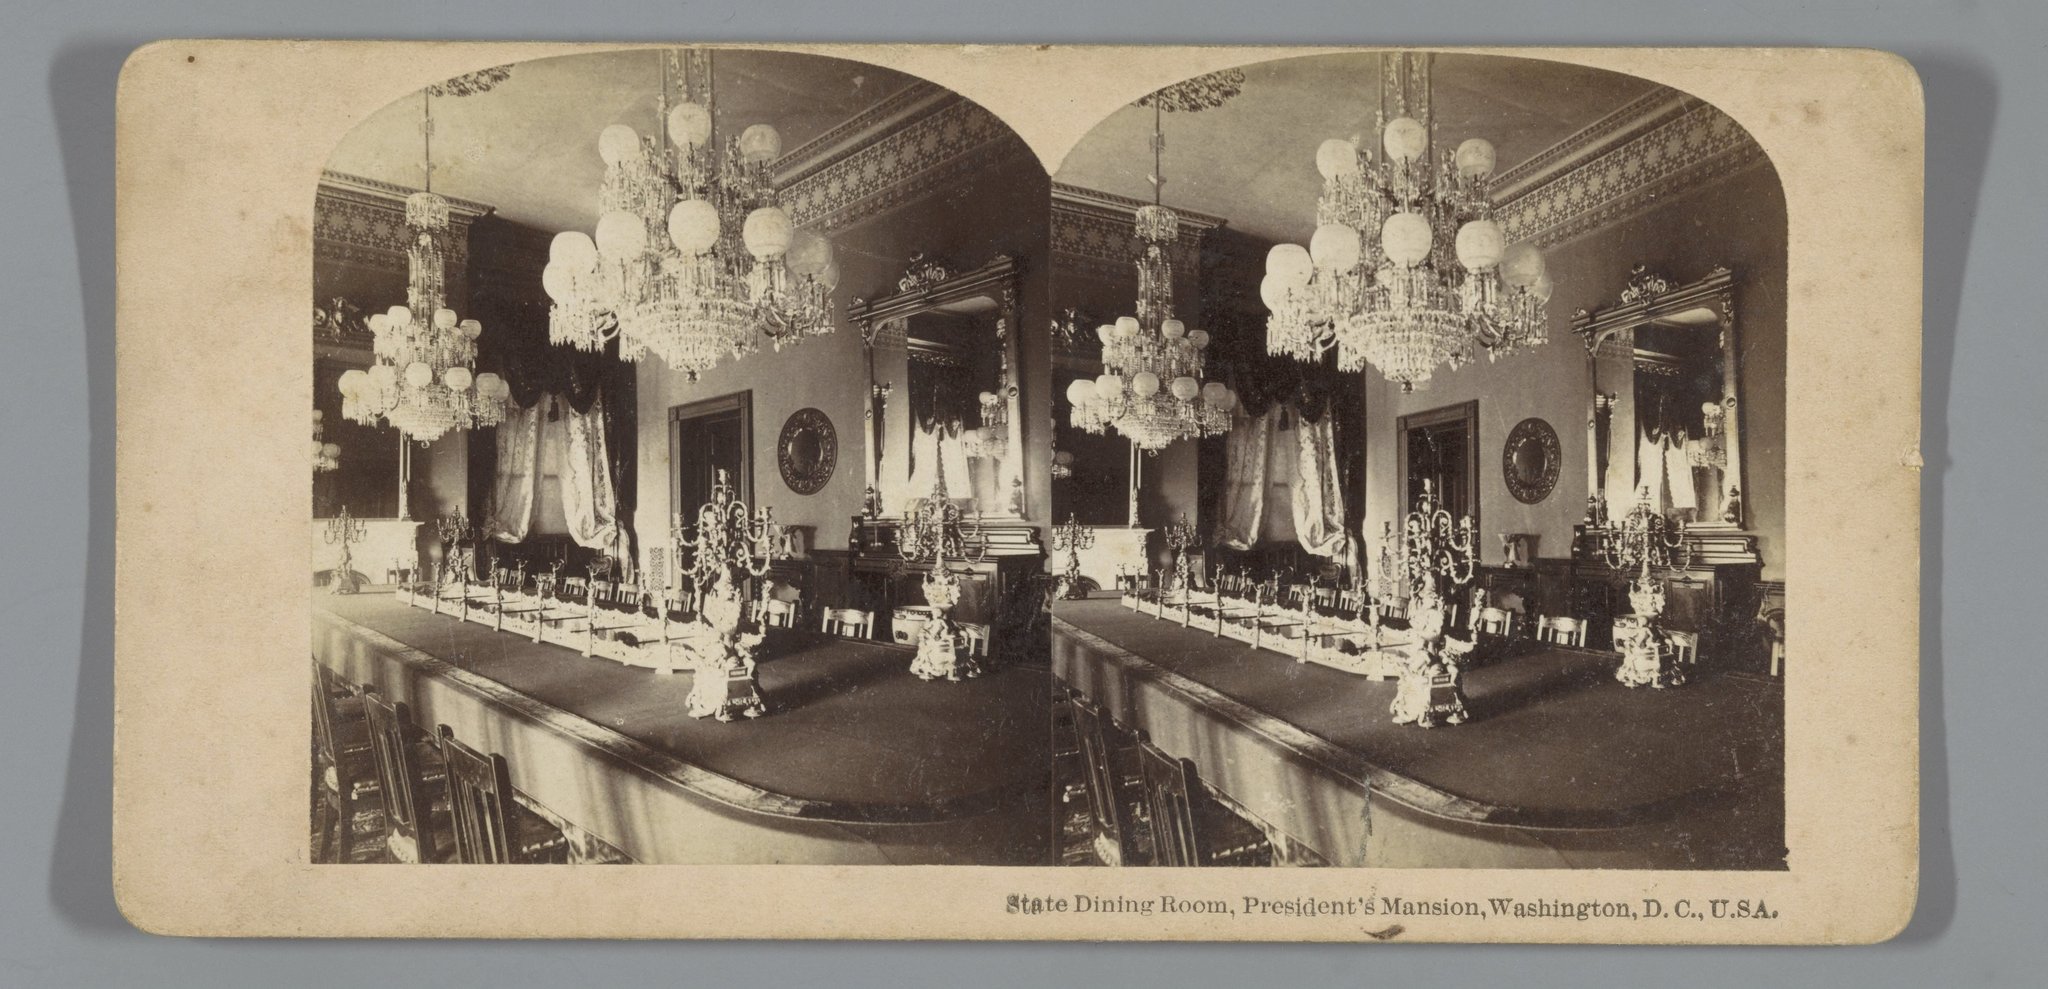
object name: stereograph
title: Eetzaal in het Witte Huis, Washington D.C.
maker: Anonymous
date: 1879-1910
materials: cardboard, paper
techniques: albumen print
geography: white house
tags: dining-room